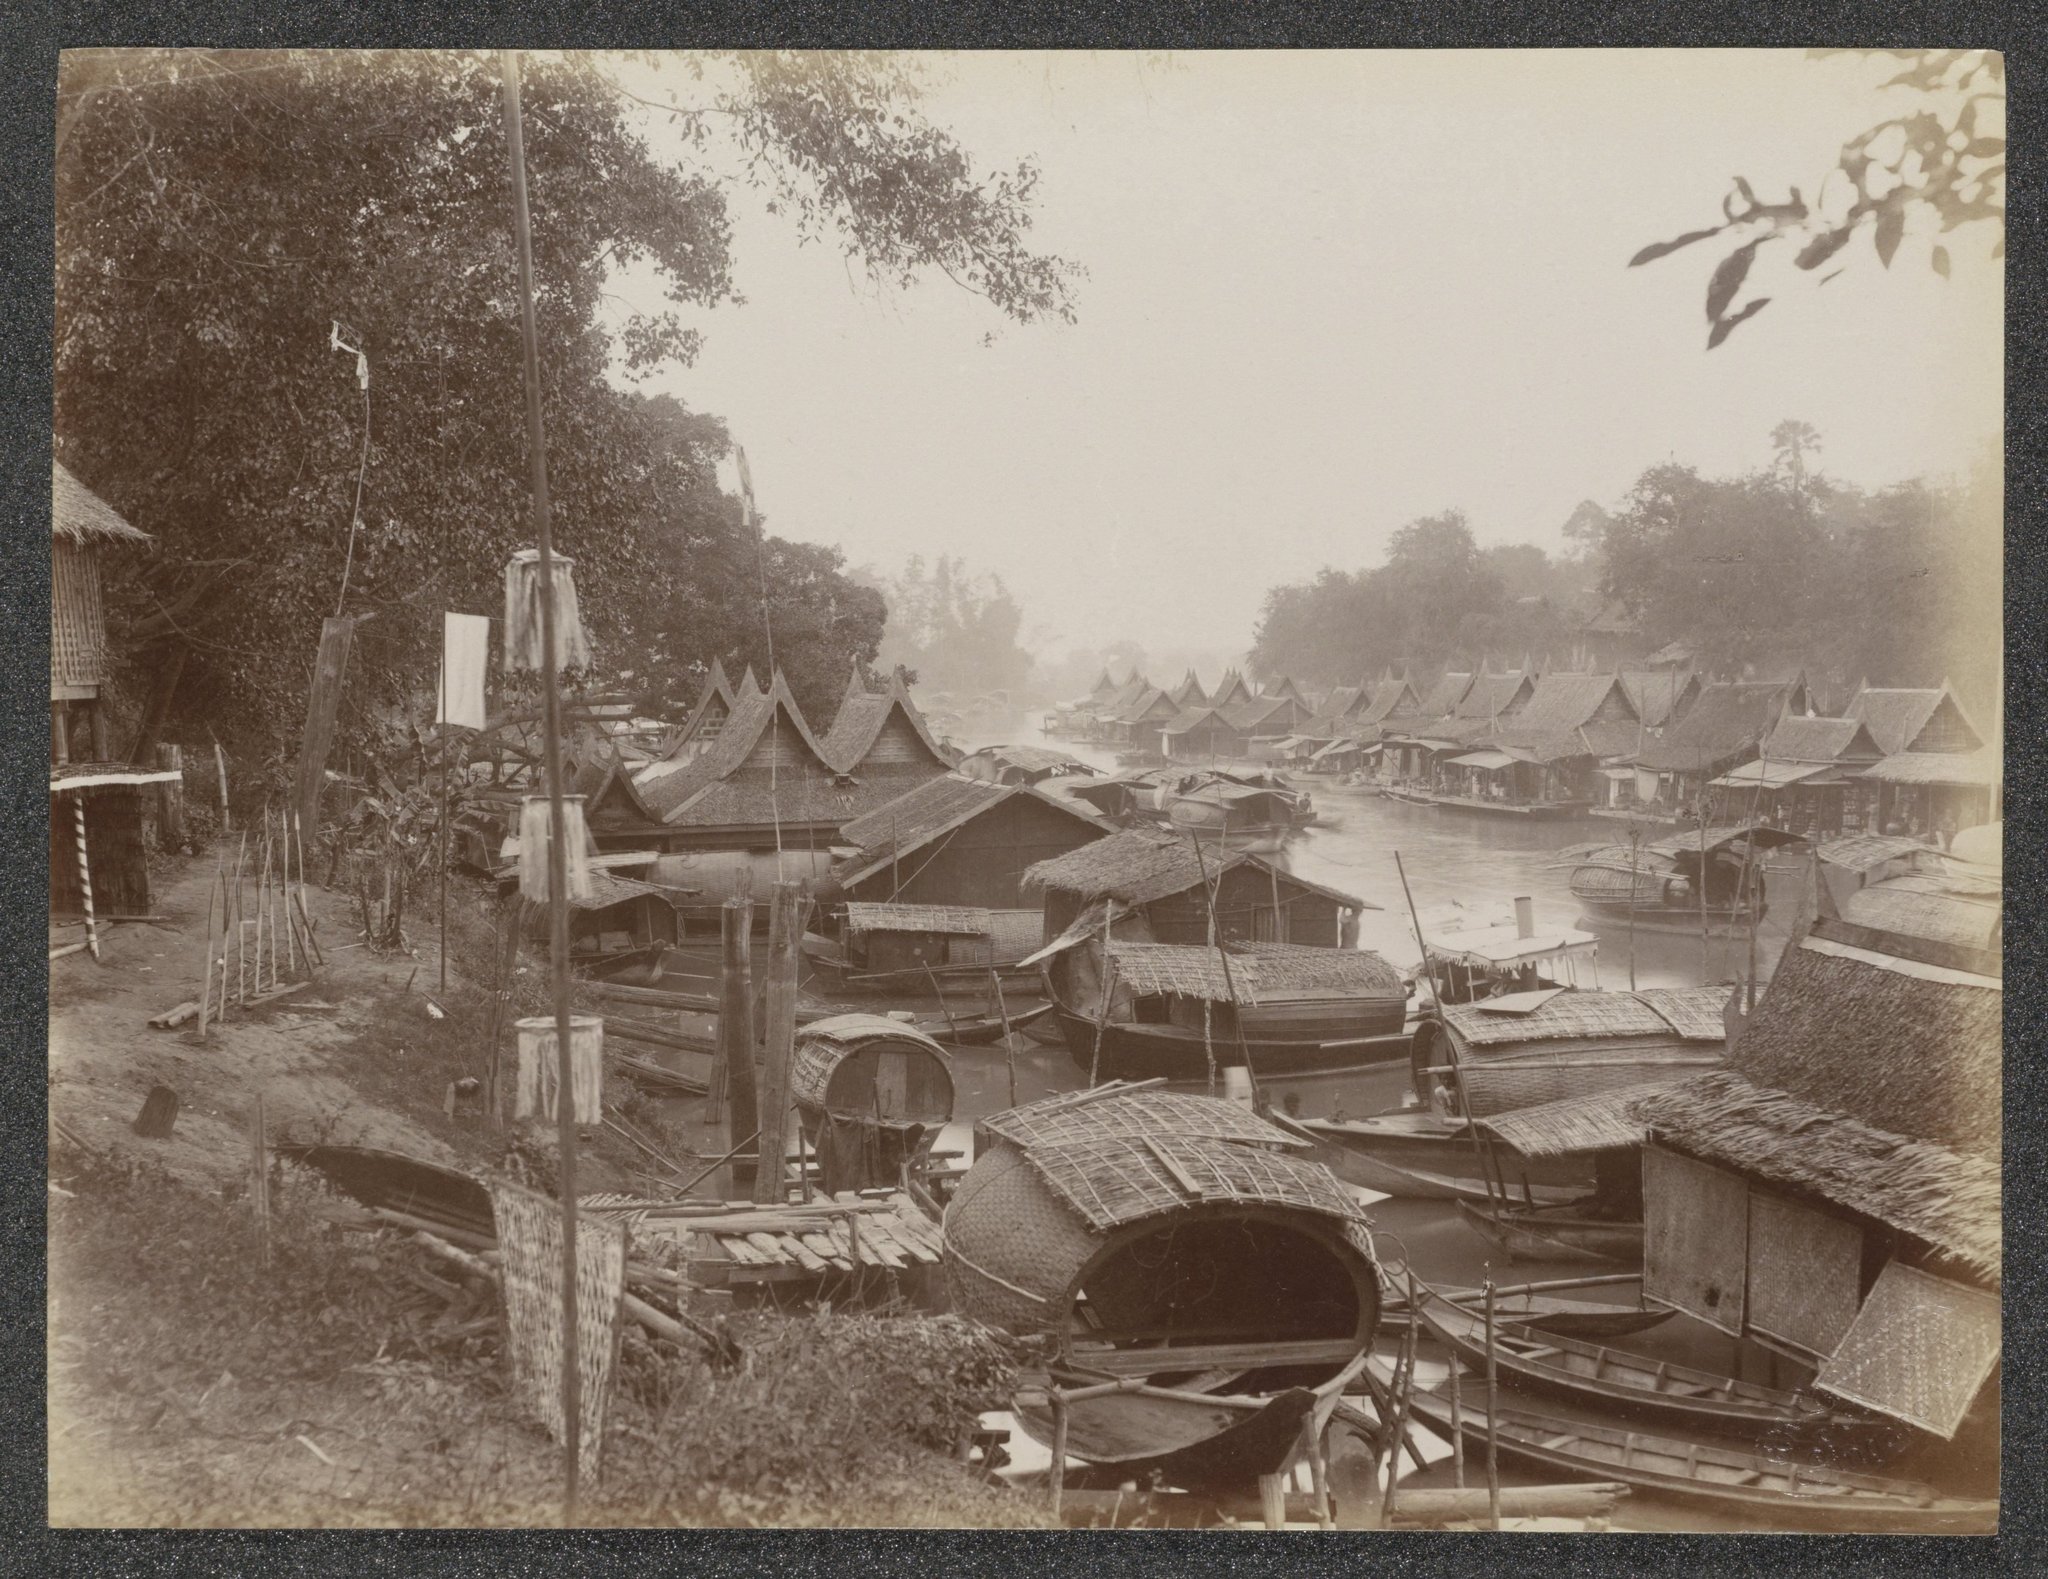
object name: album leaf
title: Boten aan de kade van een water in Bangkok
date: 1870-1900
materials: paper, photographic support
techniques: albumen print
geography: bangkok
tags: river bank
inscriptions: check stamp: ‘G.R. Lambert & Co Singapore’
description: Onderdeel van Album met 50 foto's van een reis door Zuidoost-Azië.